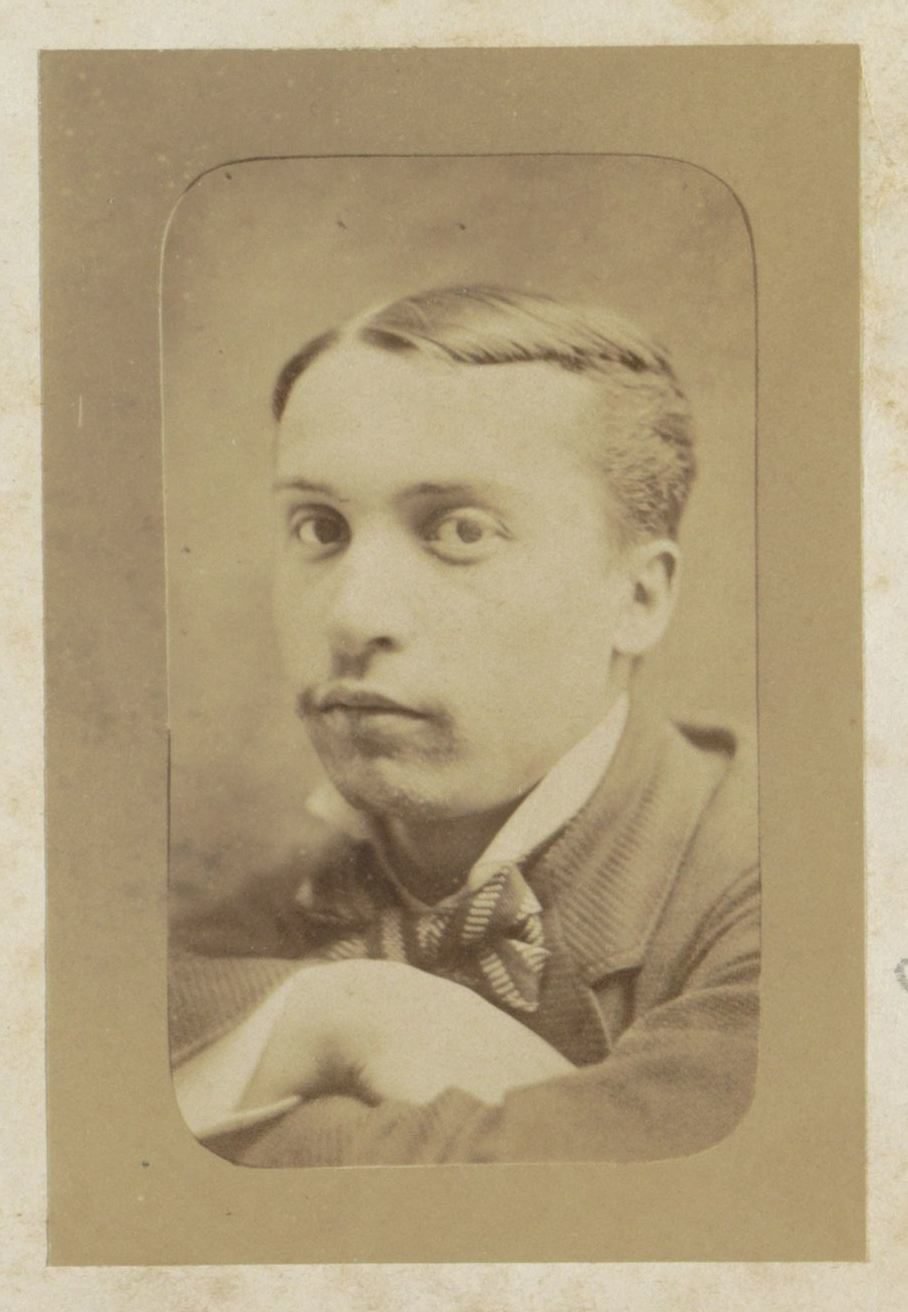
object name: photograph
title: Portret van een Fransman, aangeduid als 'Emile Amblart'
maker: Anonymous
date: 1883-1886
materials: photographic support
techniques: albumen print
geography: france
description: Onderdeel van Album van een Franse amateurfotograaf met opnames van familie, militairen, industrie, landschappen en bezienswaardigheden in Frankrijk.